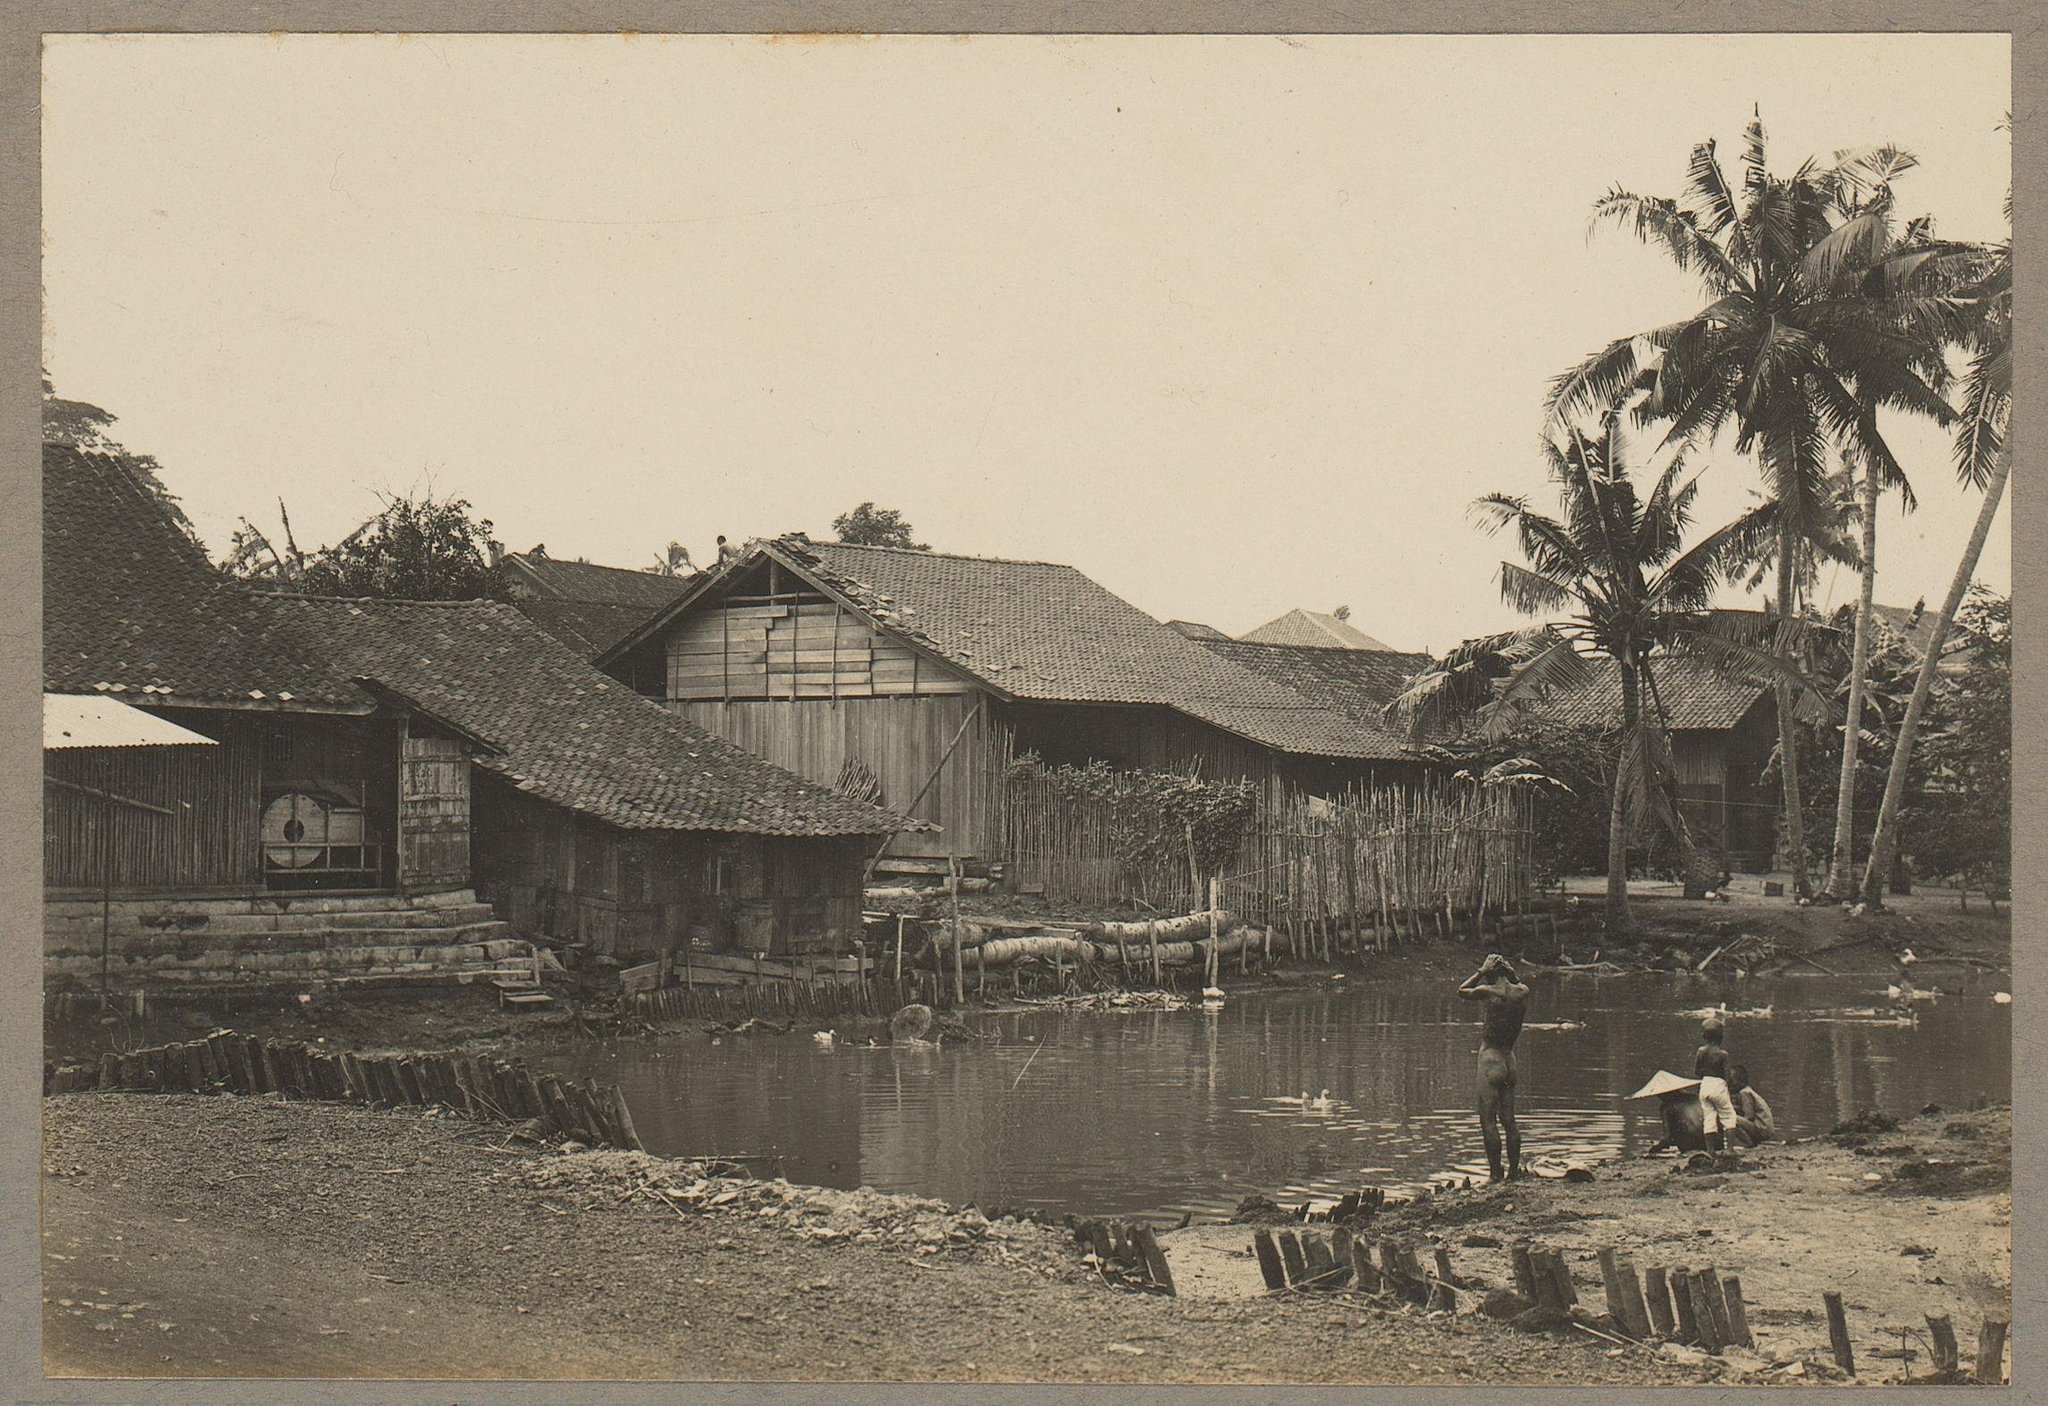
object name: photograph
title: Soengeiliatrivier achter Chineesche Kamp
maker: Anonymous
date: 1914-1919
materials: photographic support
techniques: gelatin silver print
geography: bangka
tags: robert julius boers, colonial system, mining, taking a bath - aa - in the open air, hut, cabin, lodge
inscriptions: inscription: ‘Soengeiliatrivier achter Chineesche Kamp’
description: Wassen in het water van de rivier achter woningen in het Chinese kamp van de Banka-tinwinning te Soengeiliat-Moerawang (Soengai Merawang). Onderdeel van het fotoalbum aangeboden aan Robert Julius Boers bij zijn vertrek naar Nederland in 1919 door het personeel van de Banka-tinwinning.